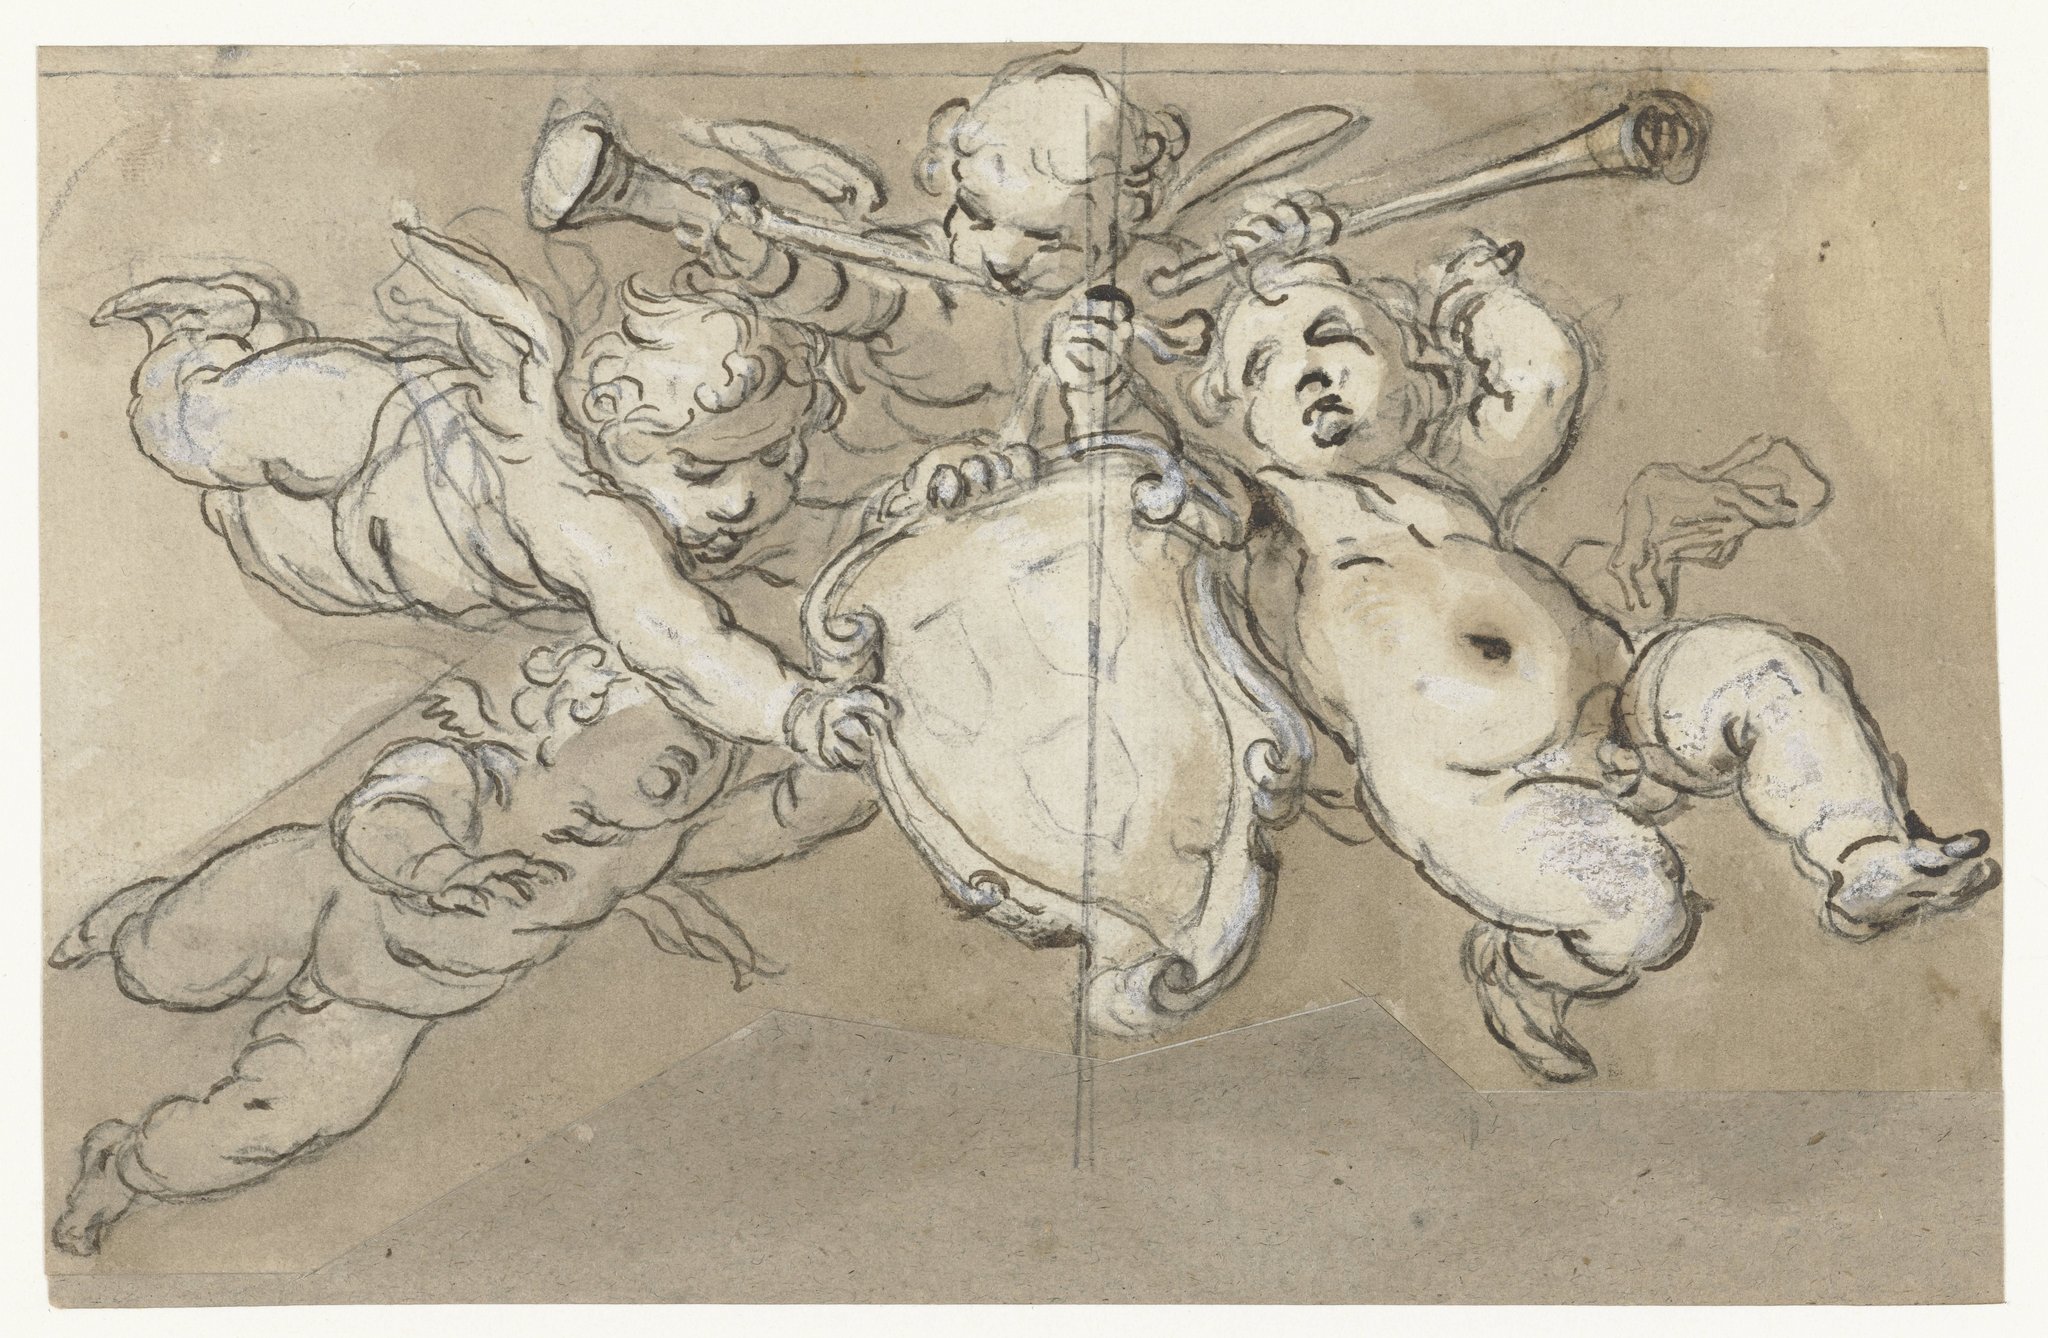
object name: drawing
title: Putti met het wapen van het Lucas Gilde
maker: abraham bloemaert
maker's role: draughtsman, painter, print maker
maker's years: 1566-1651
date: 1574-1651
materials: chalk, ink, paint, paper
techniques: brush, pen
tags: coat of arms of guild of st. luke, cupids: 'amores', 'amoretti', 'putti'